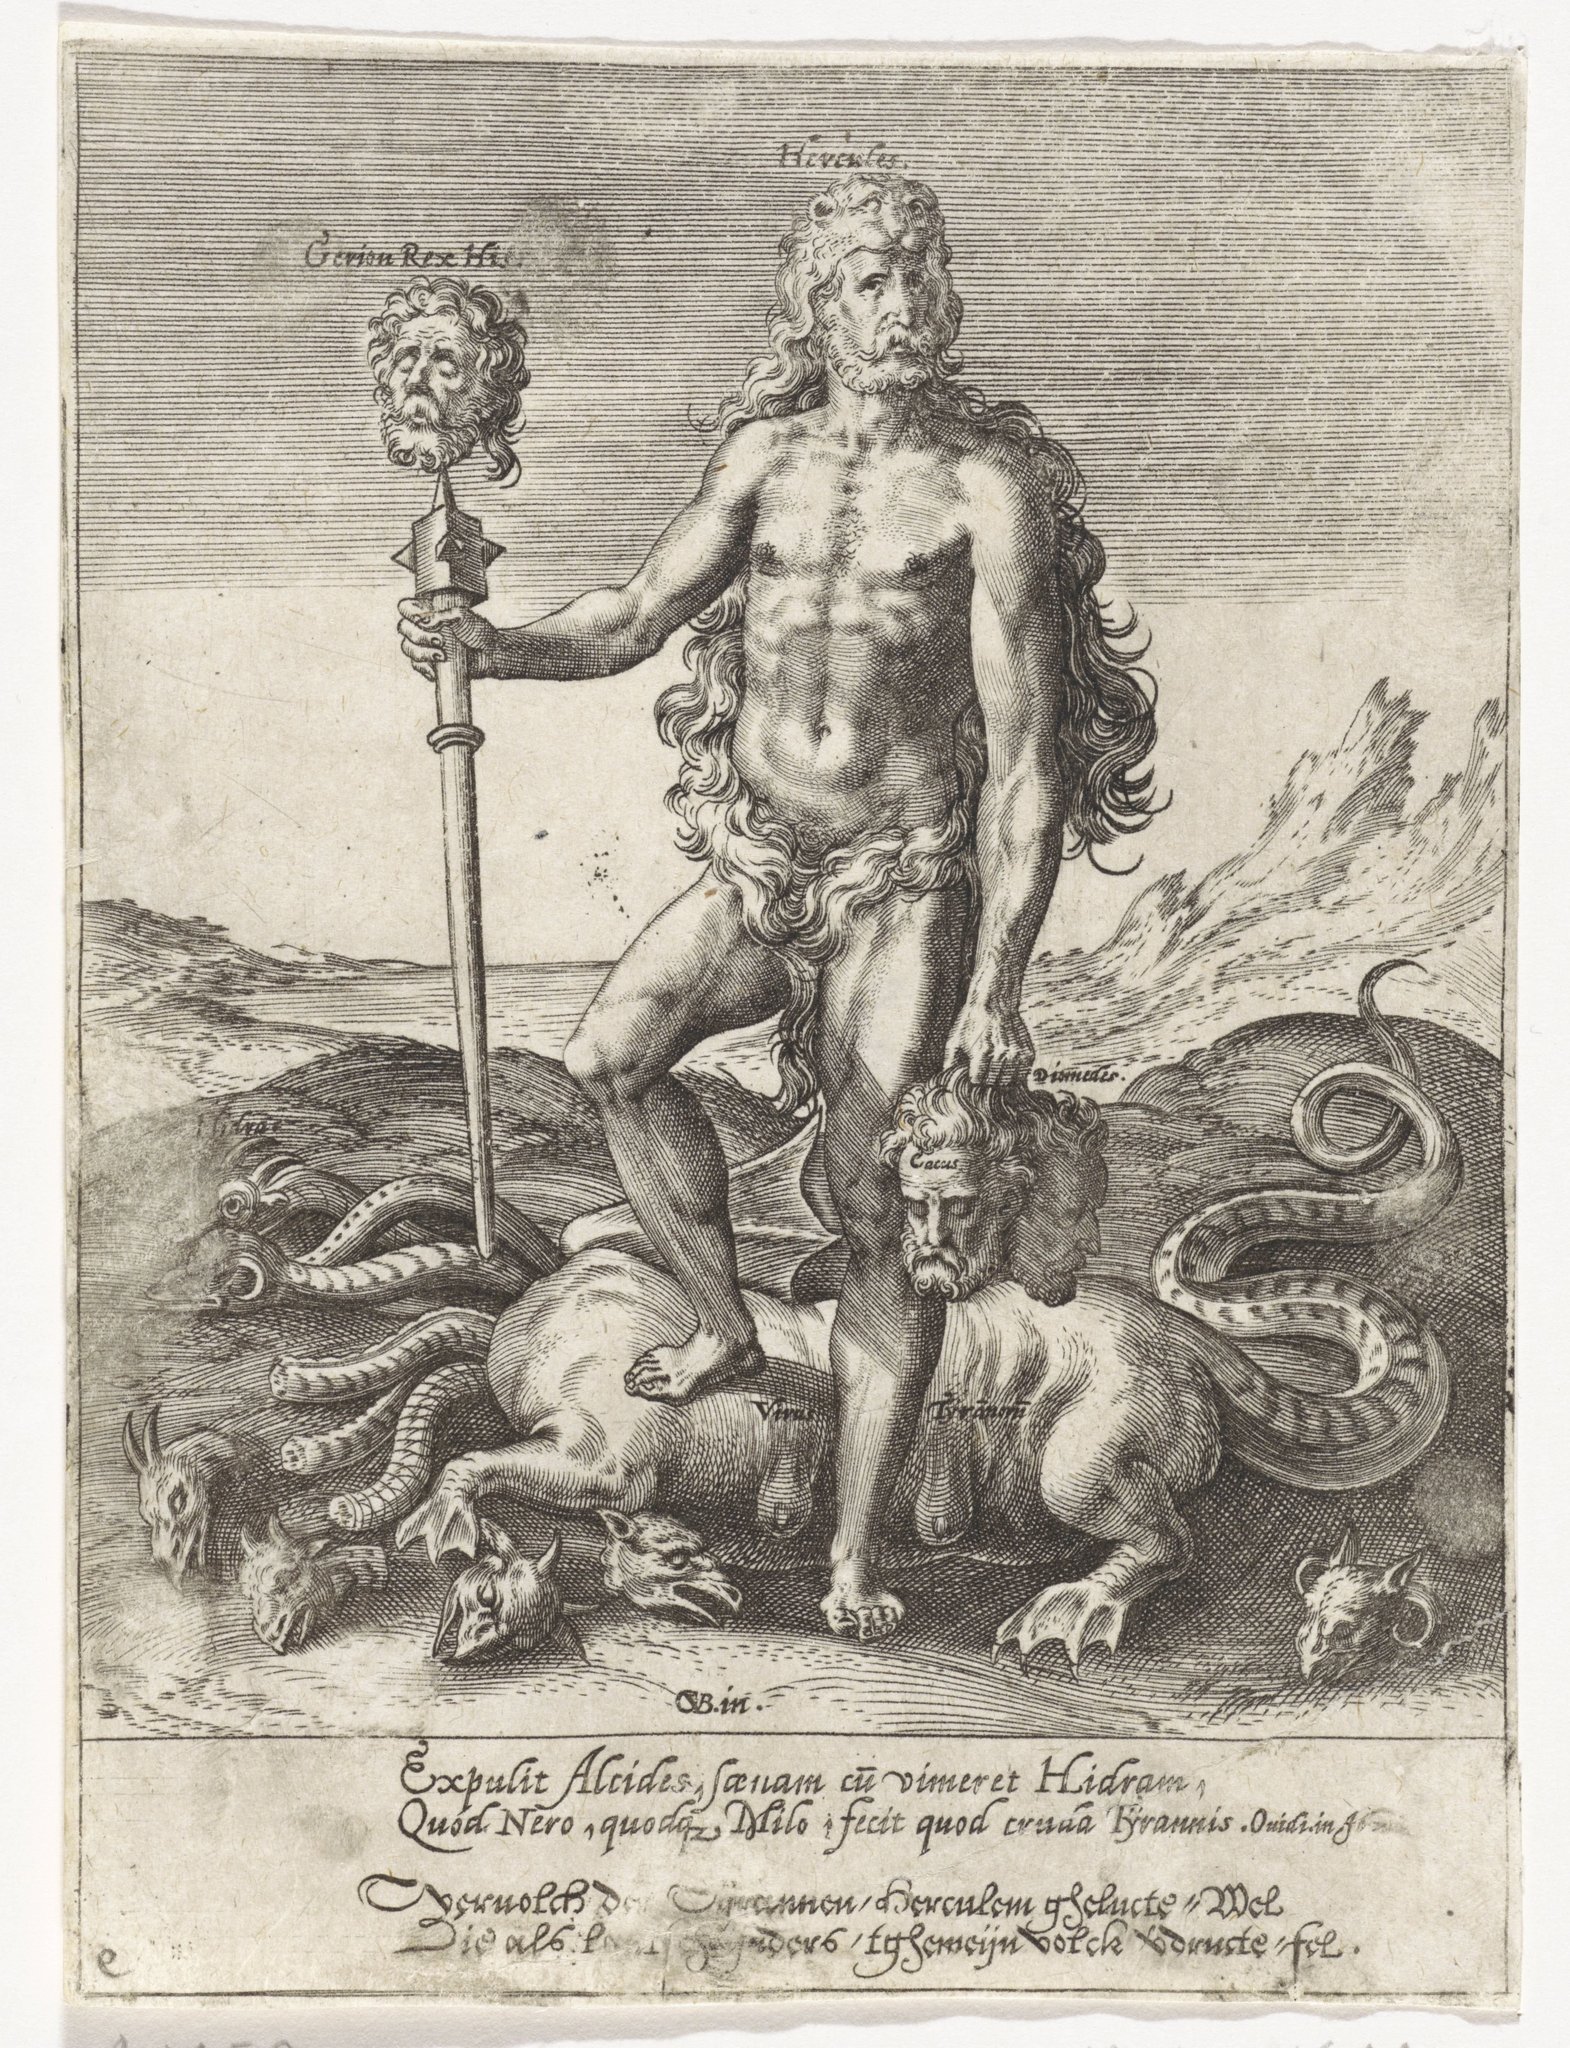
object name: print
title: Hercules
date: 1578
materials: paper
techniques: engraving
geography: antwerp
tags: diomedes - death, cacus, the fire-breathing monster is killed in his cave by hercules (+ variant), the monster geryon - death, (2) the hydra of lerna is killed by hercules, violent death by beheading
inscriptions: collector's mark: Lugt 2228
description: Landschap met Hercules. In zijn hand houdt hij de hoofden van koning Diomedes en de veedief Cacus, op zijn knots prijkt het hoofd van de reus Geryon. Met zijn voet staat hij op de meerkoppige hydra van Lerna, het door hem verslagen watermonster. In de marge een tweeregelig onderschrift uit het boek van Ovidius in het Latijn en in het Nederlands.